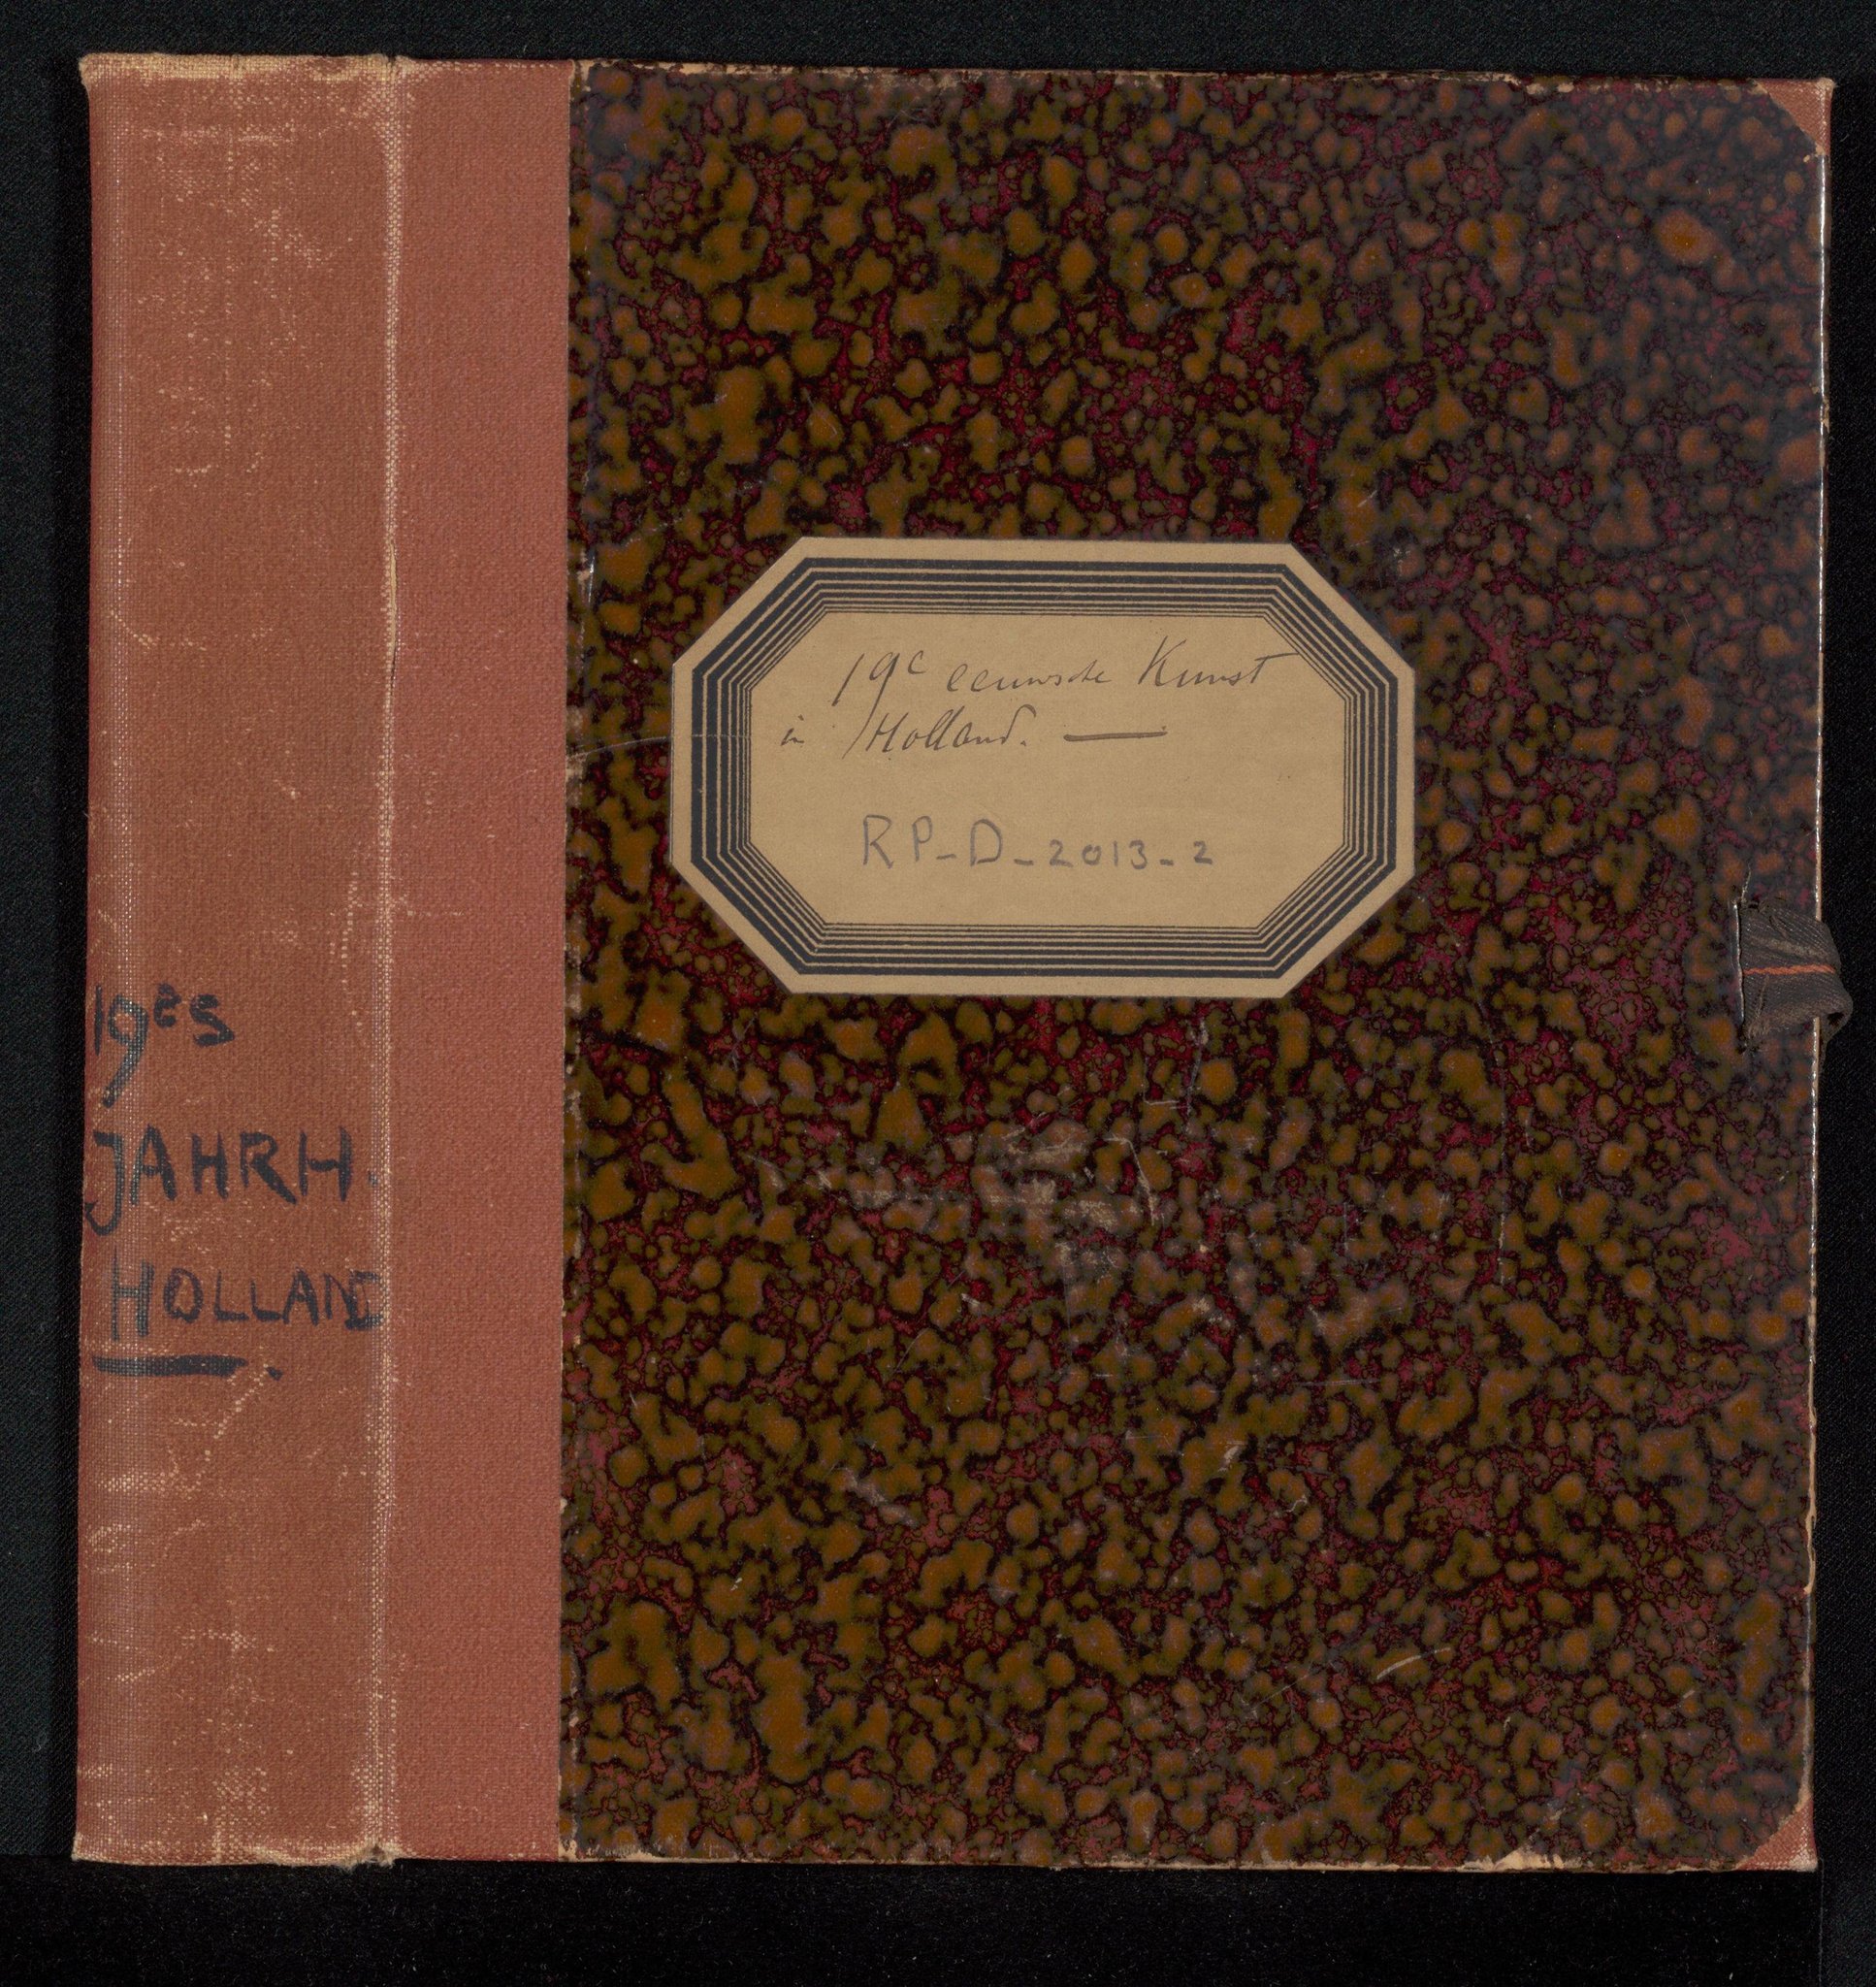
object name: file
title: Dossier Willem Vogelsang / '19e eeuwse kunst in Holland'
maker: willem vogelsang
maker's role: draughtsman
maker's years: 1875-1954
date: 1875-1954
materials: ink, paper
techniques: pen, printing, writing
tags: leiden, utrecht, draughtsman, willem vogelsang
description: Het dossier bevat aantekeningen en onderzoeksmateriaal van Willem Vogelsang met betrekking tot Nederlandse kunstenaars, alsmede publicaties, knipsels en documenten met betrekking tot de persoon Willem Vogelsang.